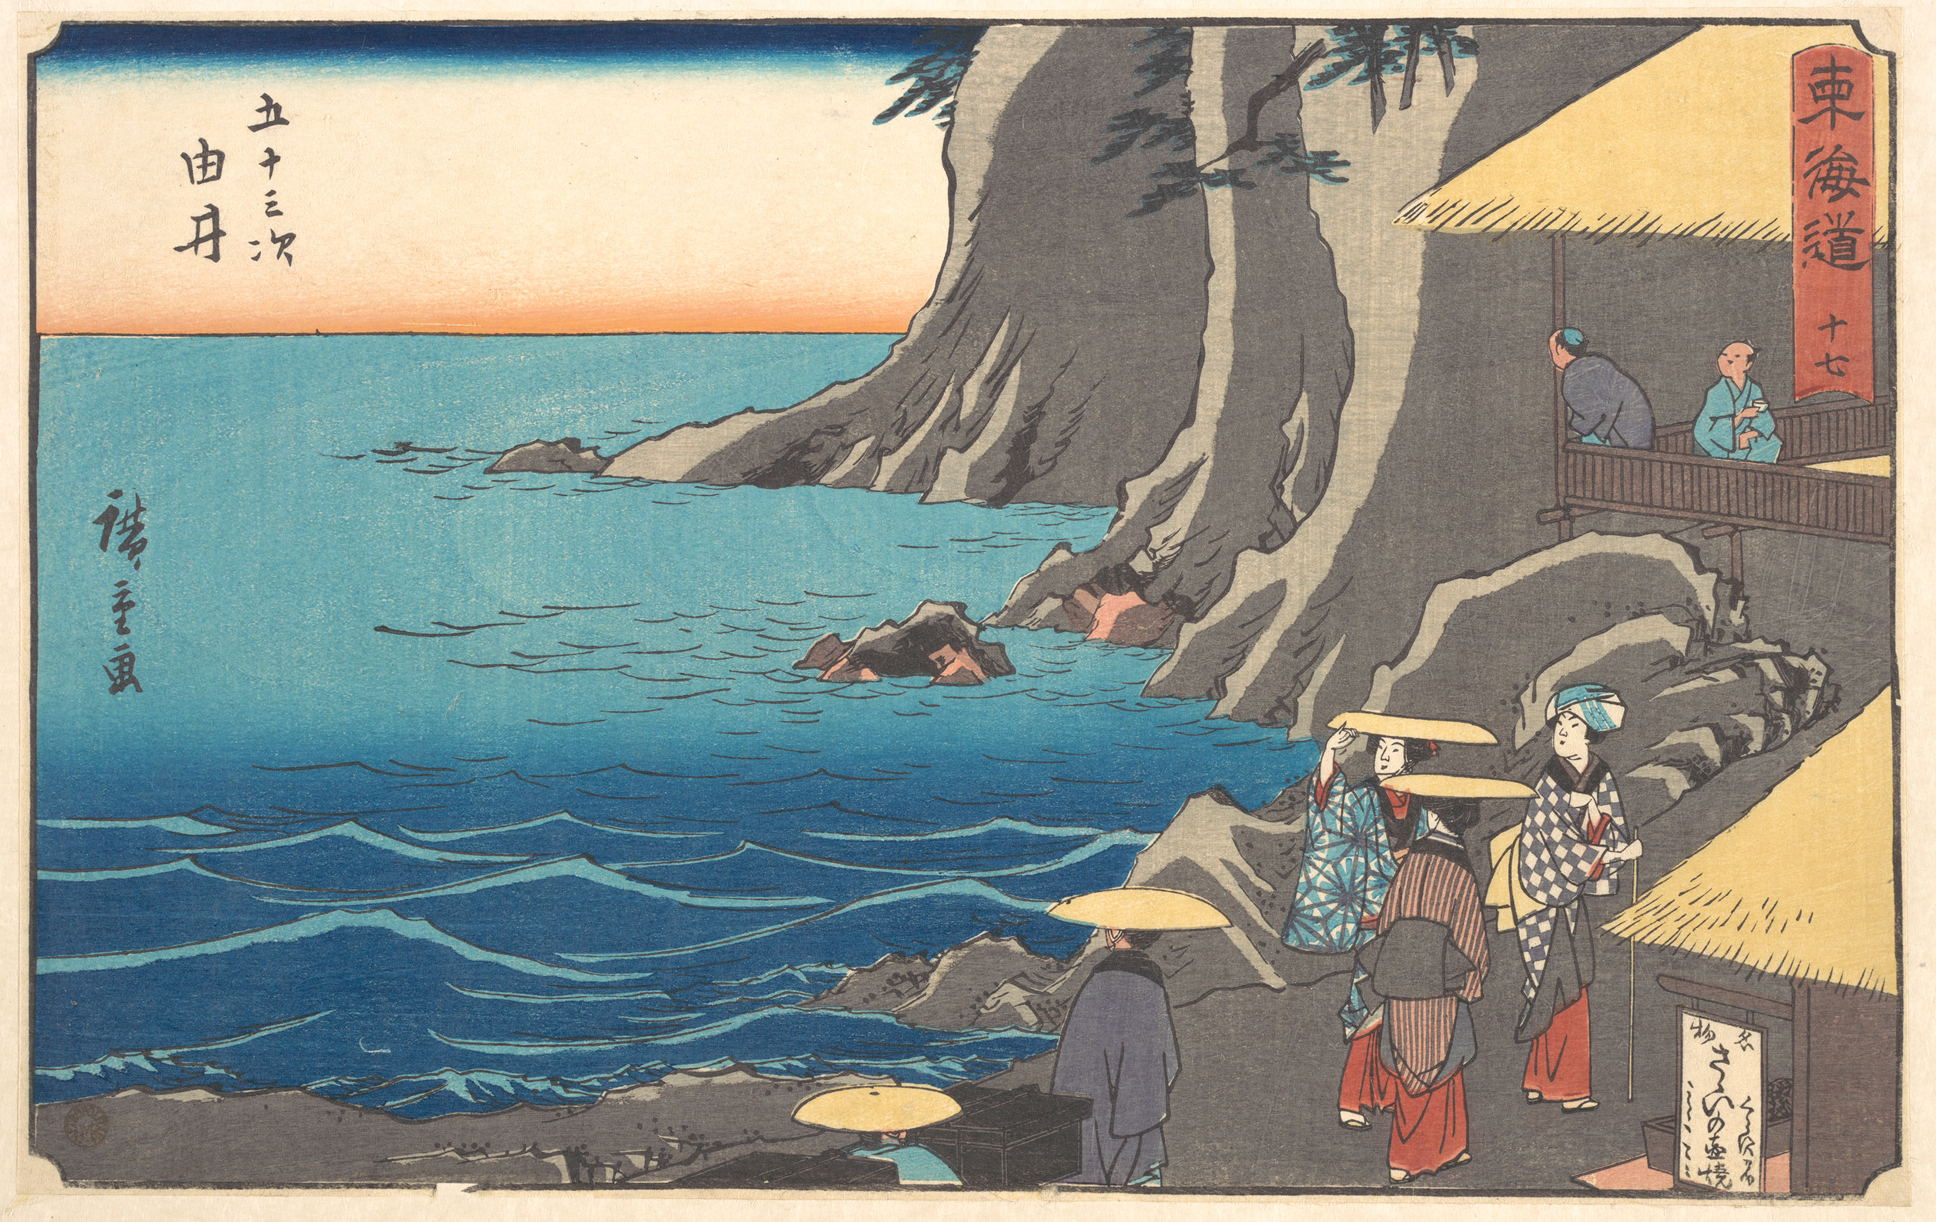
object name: print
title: Yui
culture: japanese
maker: utagawa hiroshige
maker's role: artist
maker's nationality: japanese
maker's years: 1797-1858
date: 1840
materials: ink, paper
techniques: woodblock print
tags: men,women,seas,tea houses